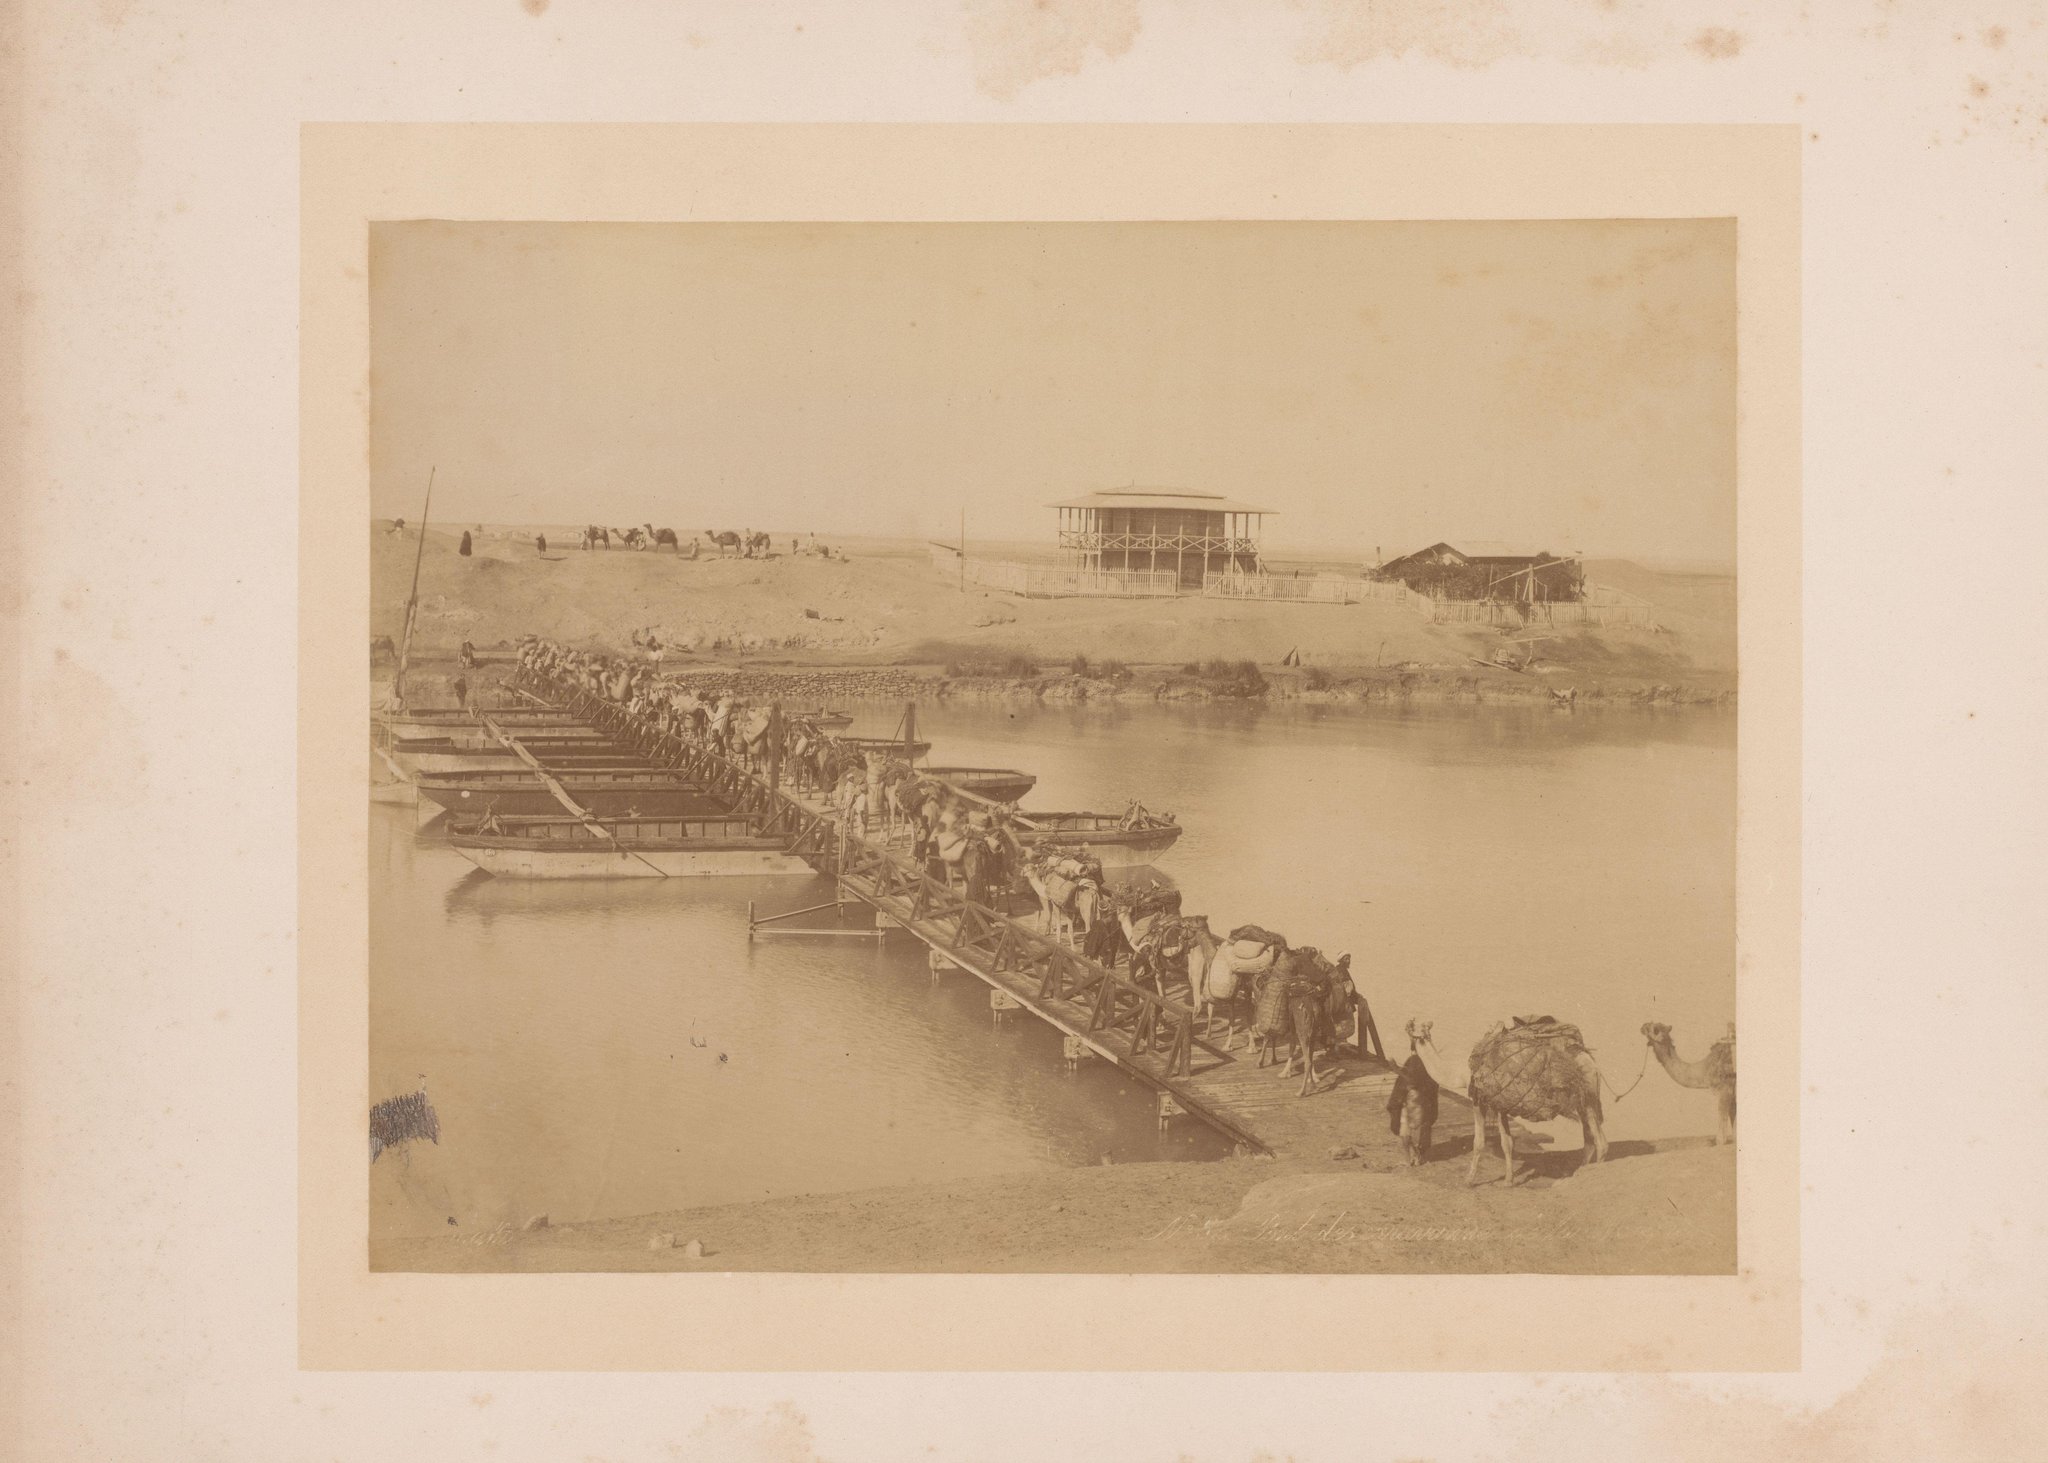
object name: photograph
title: Karavaan met kamelen of dromedarissen op een pontoonbrug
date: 1870-1910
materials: cardboard, paper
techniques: albumen print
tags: hoofed animals: camel, pontoon bridge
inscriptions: number: ‘No [...]’